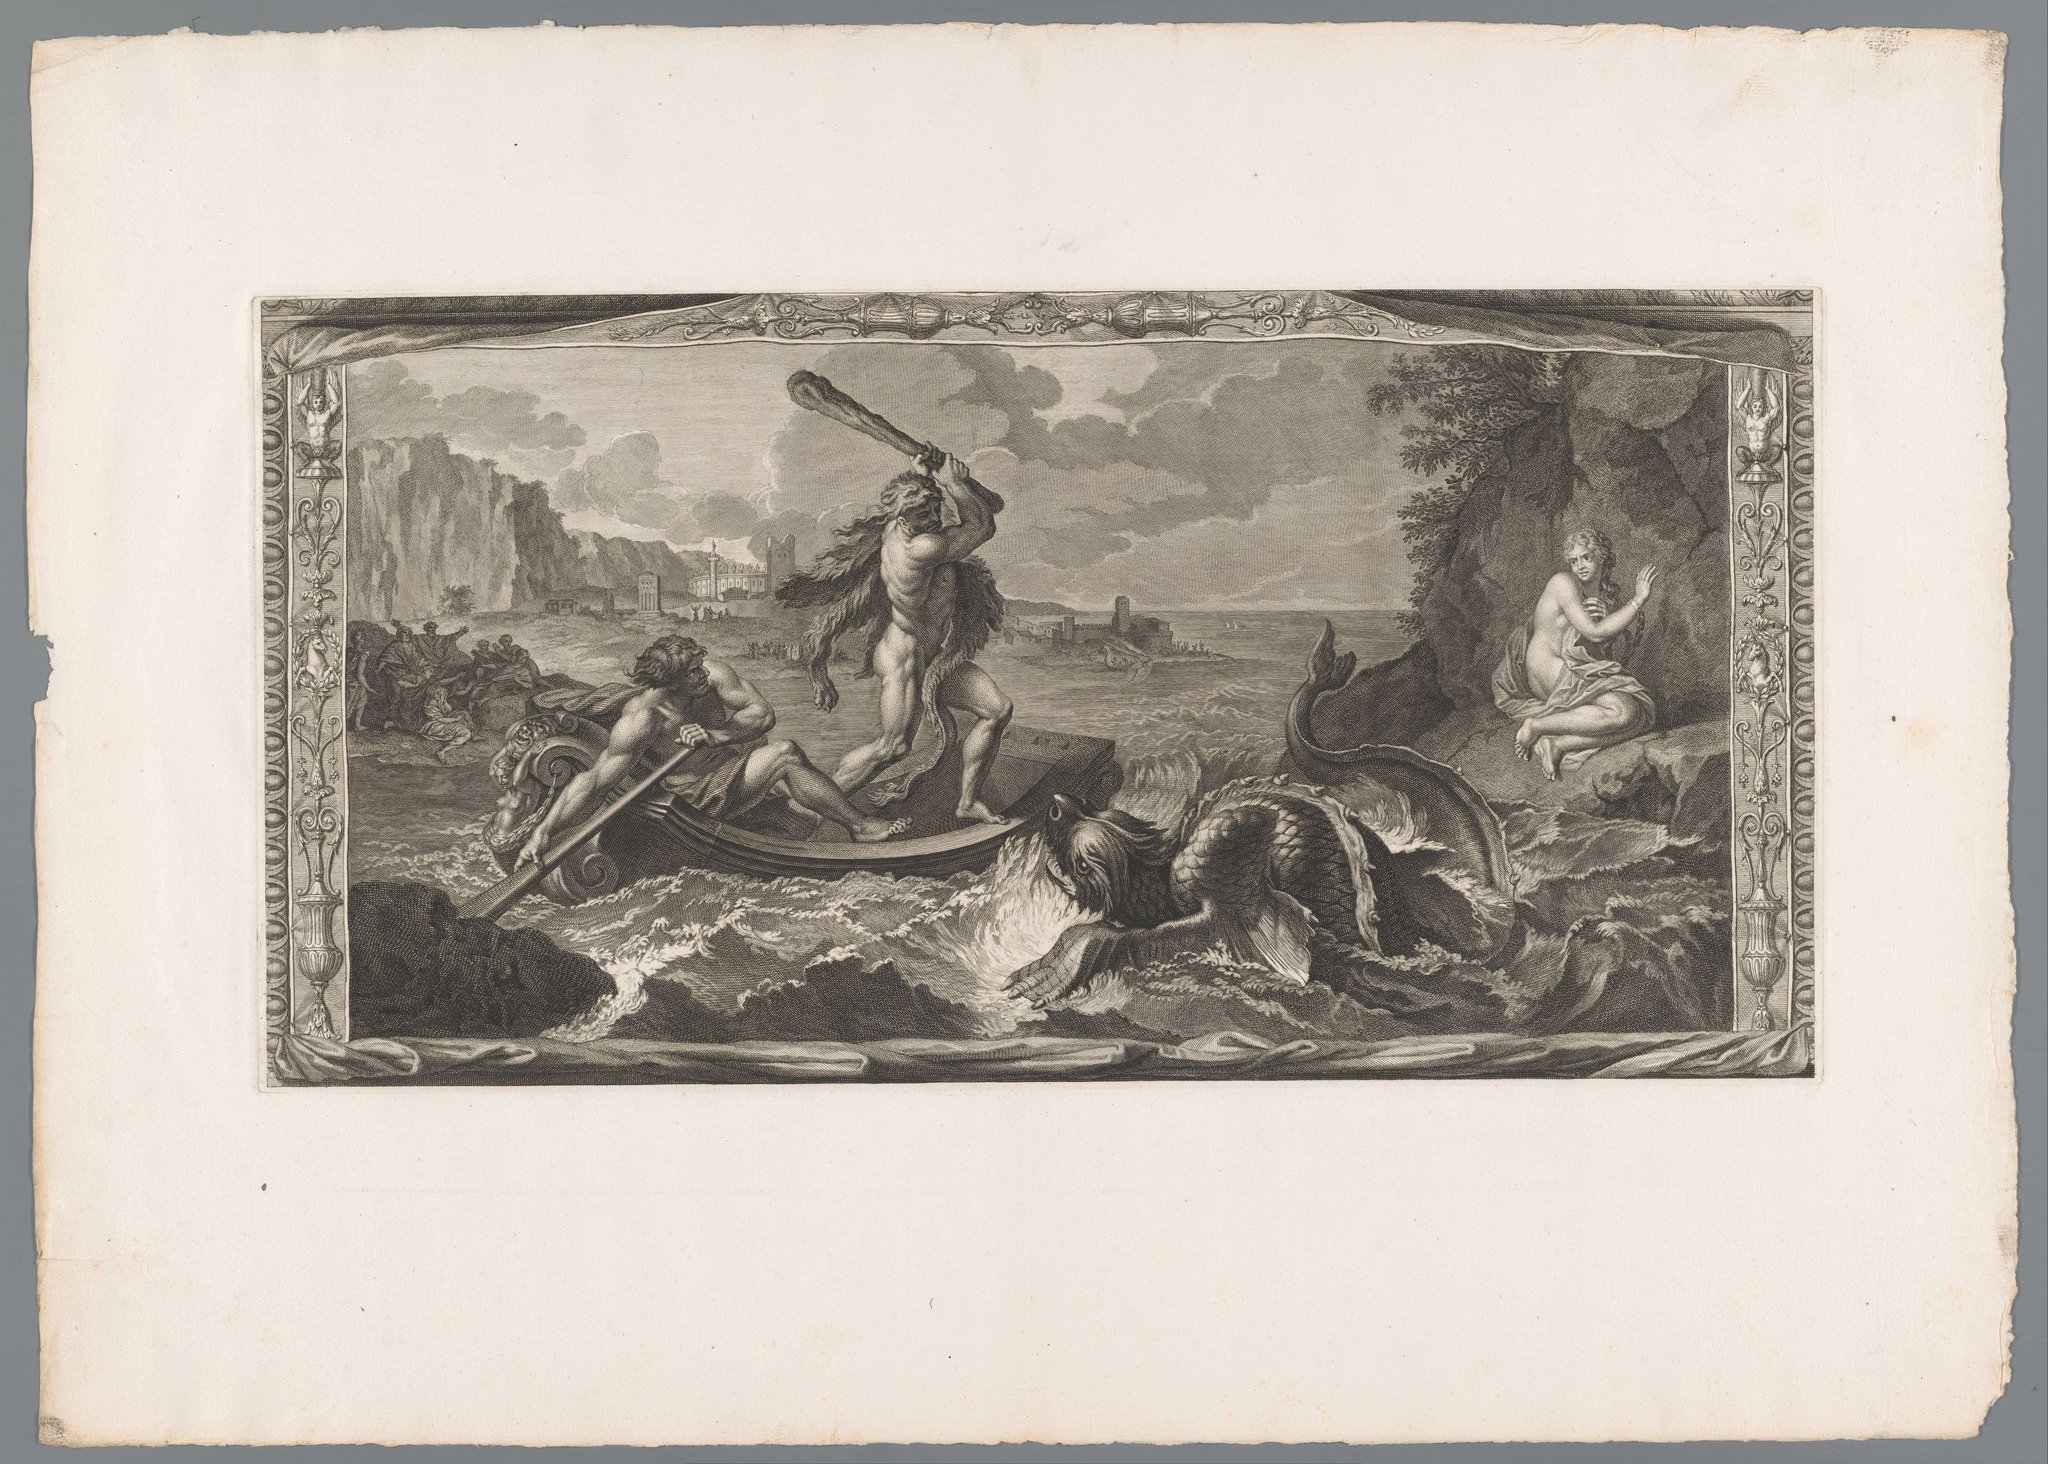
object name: print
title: Hercules en Hesione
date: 1713-1719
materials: paper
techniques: engraving, etching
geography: amsterdam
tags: hercules liberates hesione, laomedon's daughter, by killing the sea monster, (decorated) ceiling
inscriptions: collector's mark: Lugt 2228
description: Hercules redt Hesione van het zeemonster. Staande in een boot slaat Hercules met zijn knots het monster neer. Hesione zit rechts vastgeketend aan de rots. Prent maakt deel uit van een serie prenten, die samen het geschilderde plafond met de Apotheose van Hercules in het Hôtel Lambert te Parijs voorstellen.